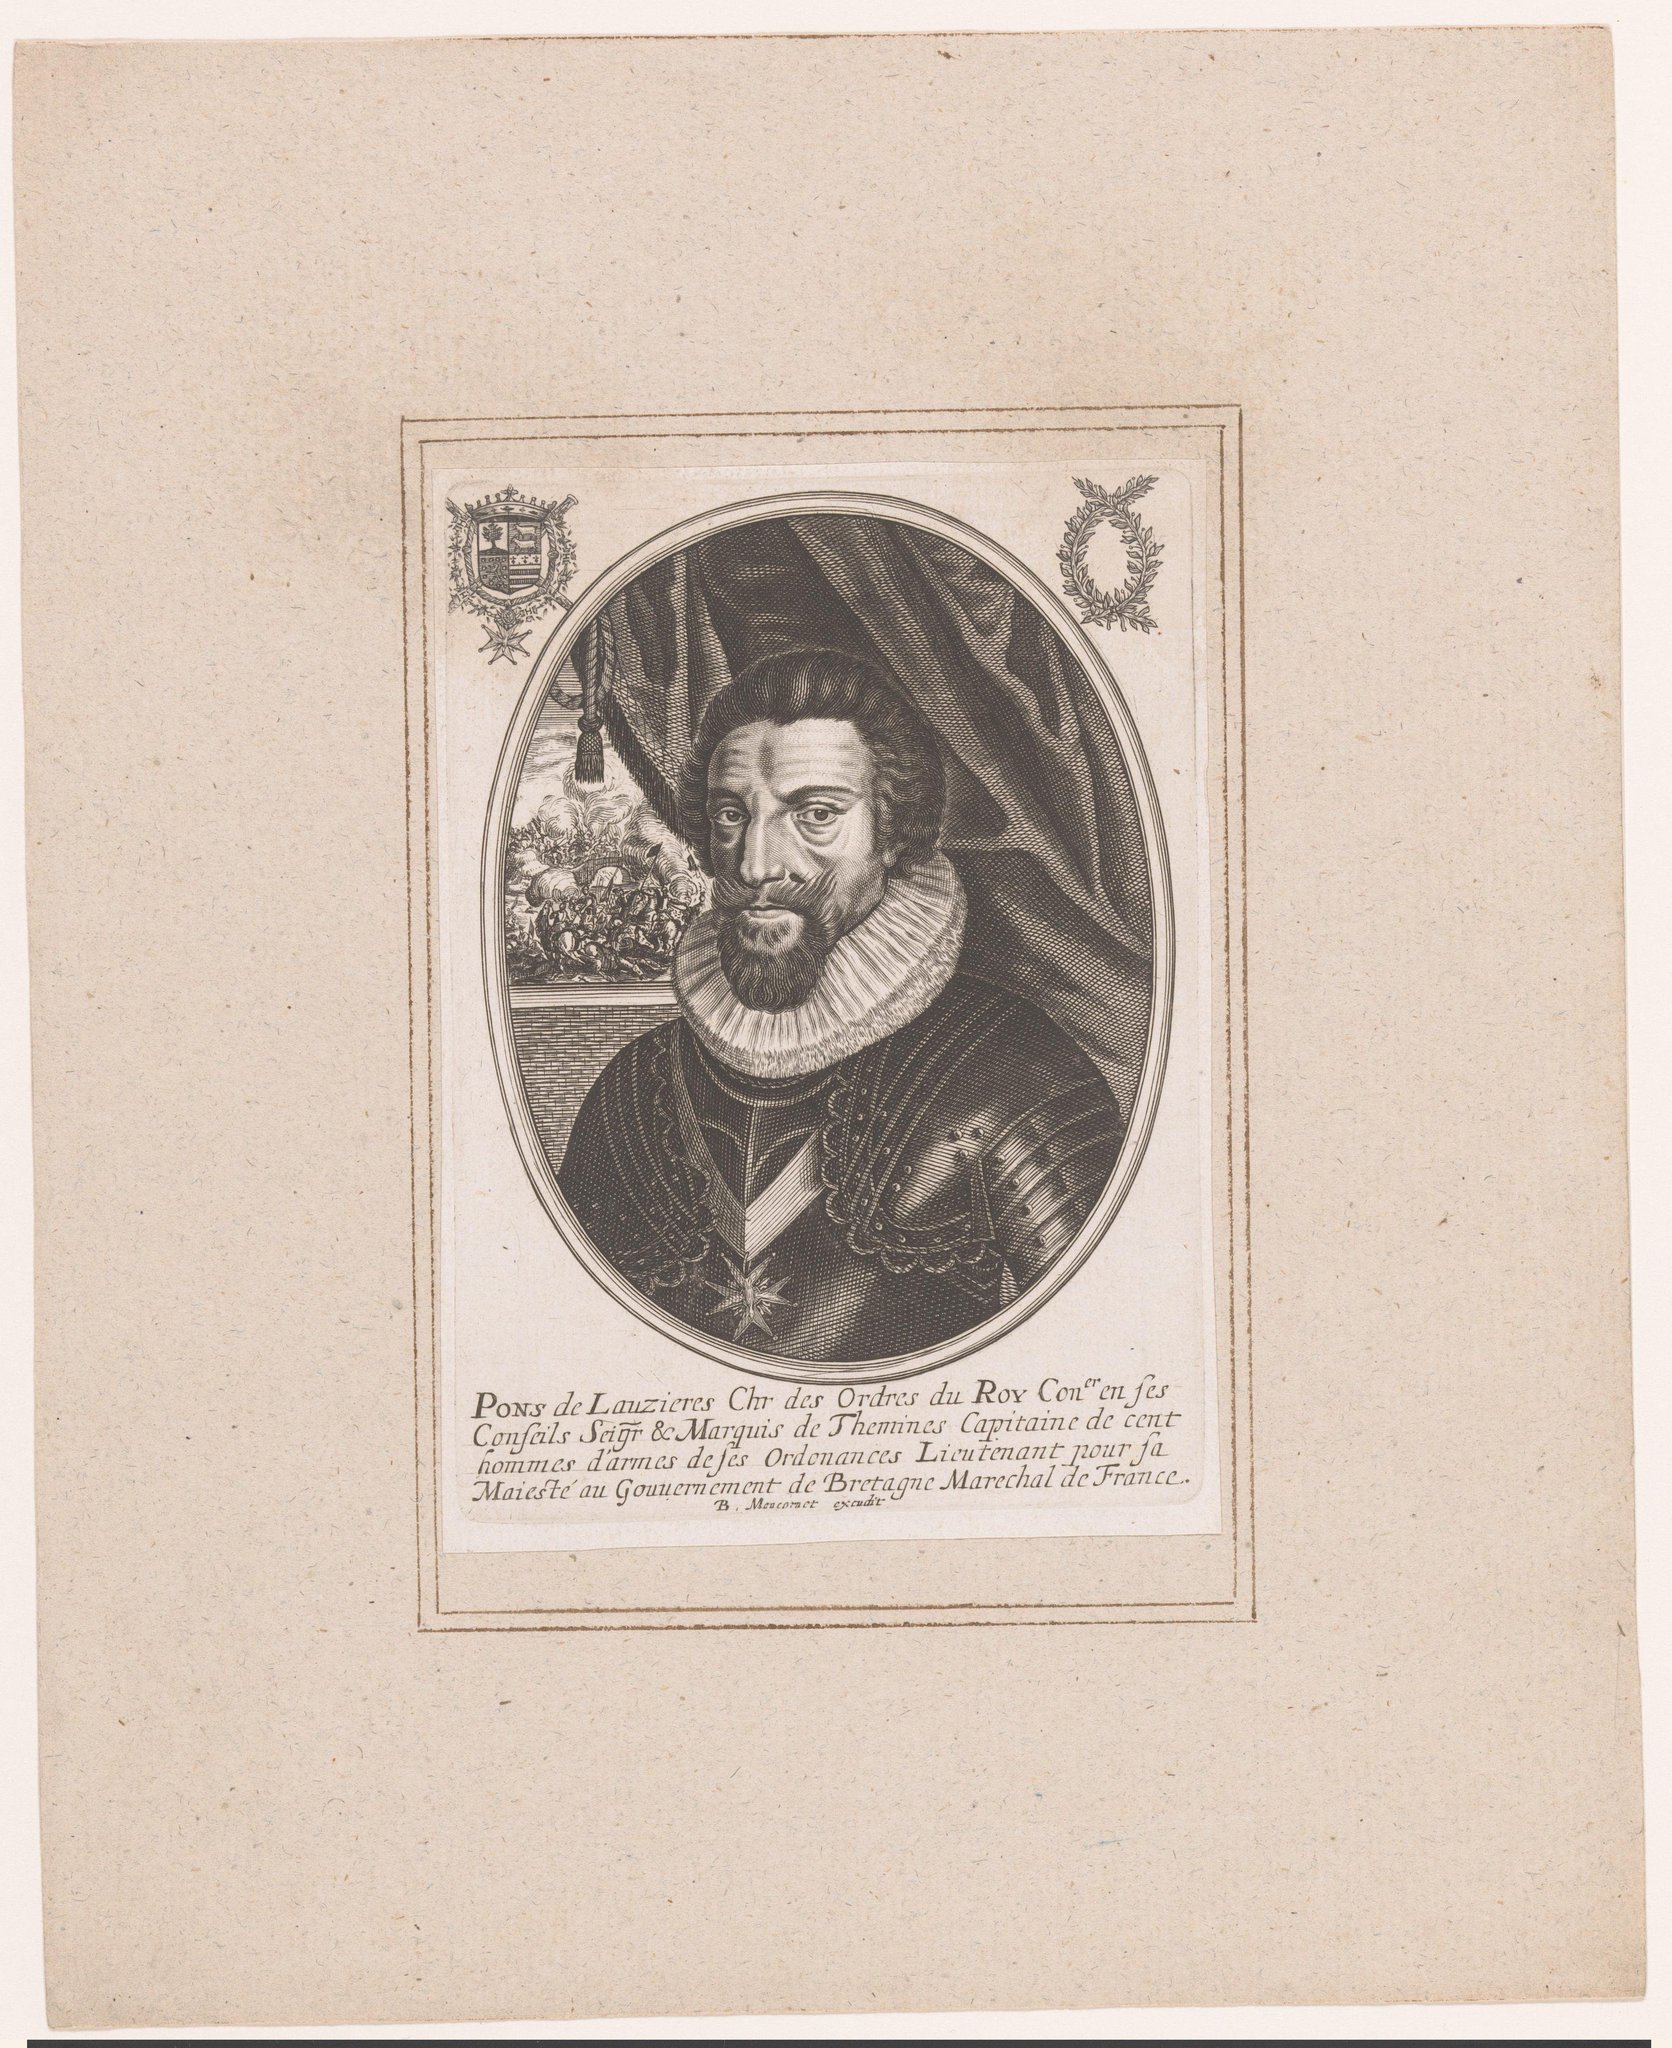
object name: print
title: Portret van Pons de Lauzières-Thémines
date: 1610-1668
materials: paper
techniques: engraving, etching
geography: paris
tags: commander-in-chief, general, marshal, historical persons, armorial bearing, heraldry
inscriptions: collector's mark: Lugt 2228